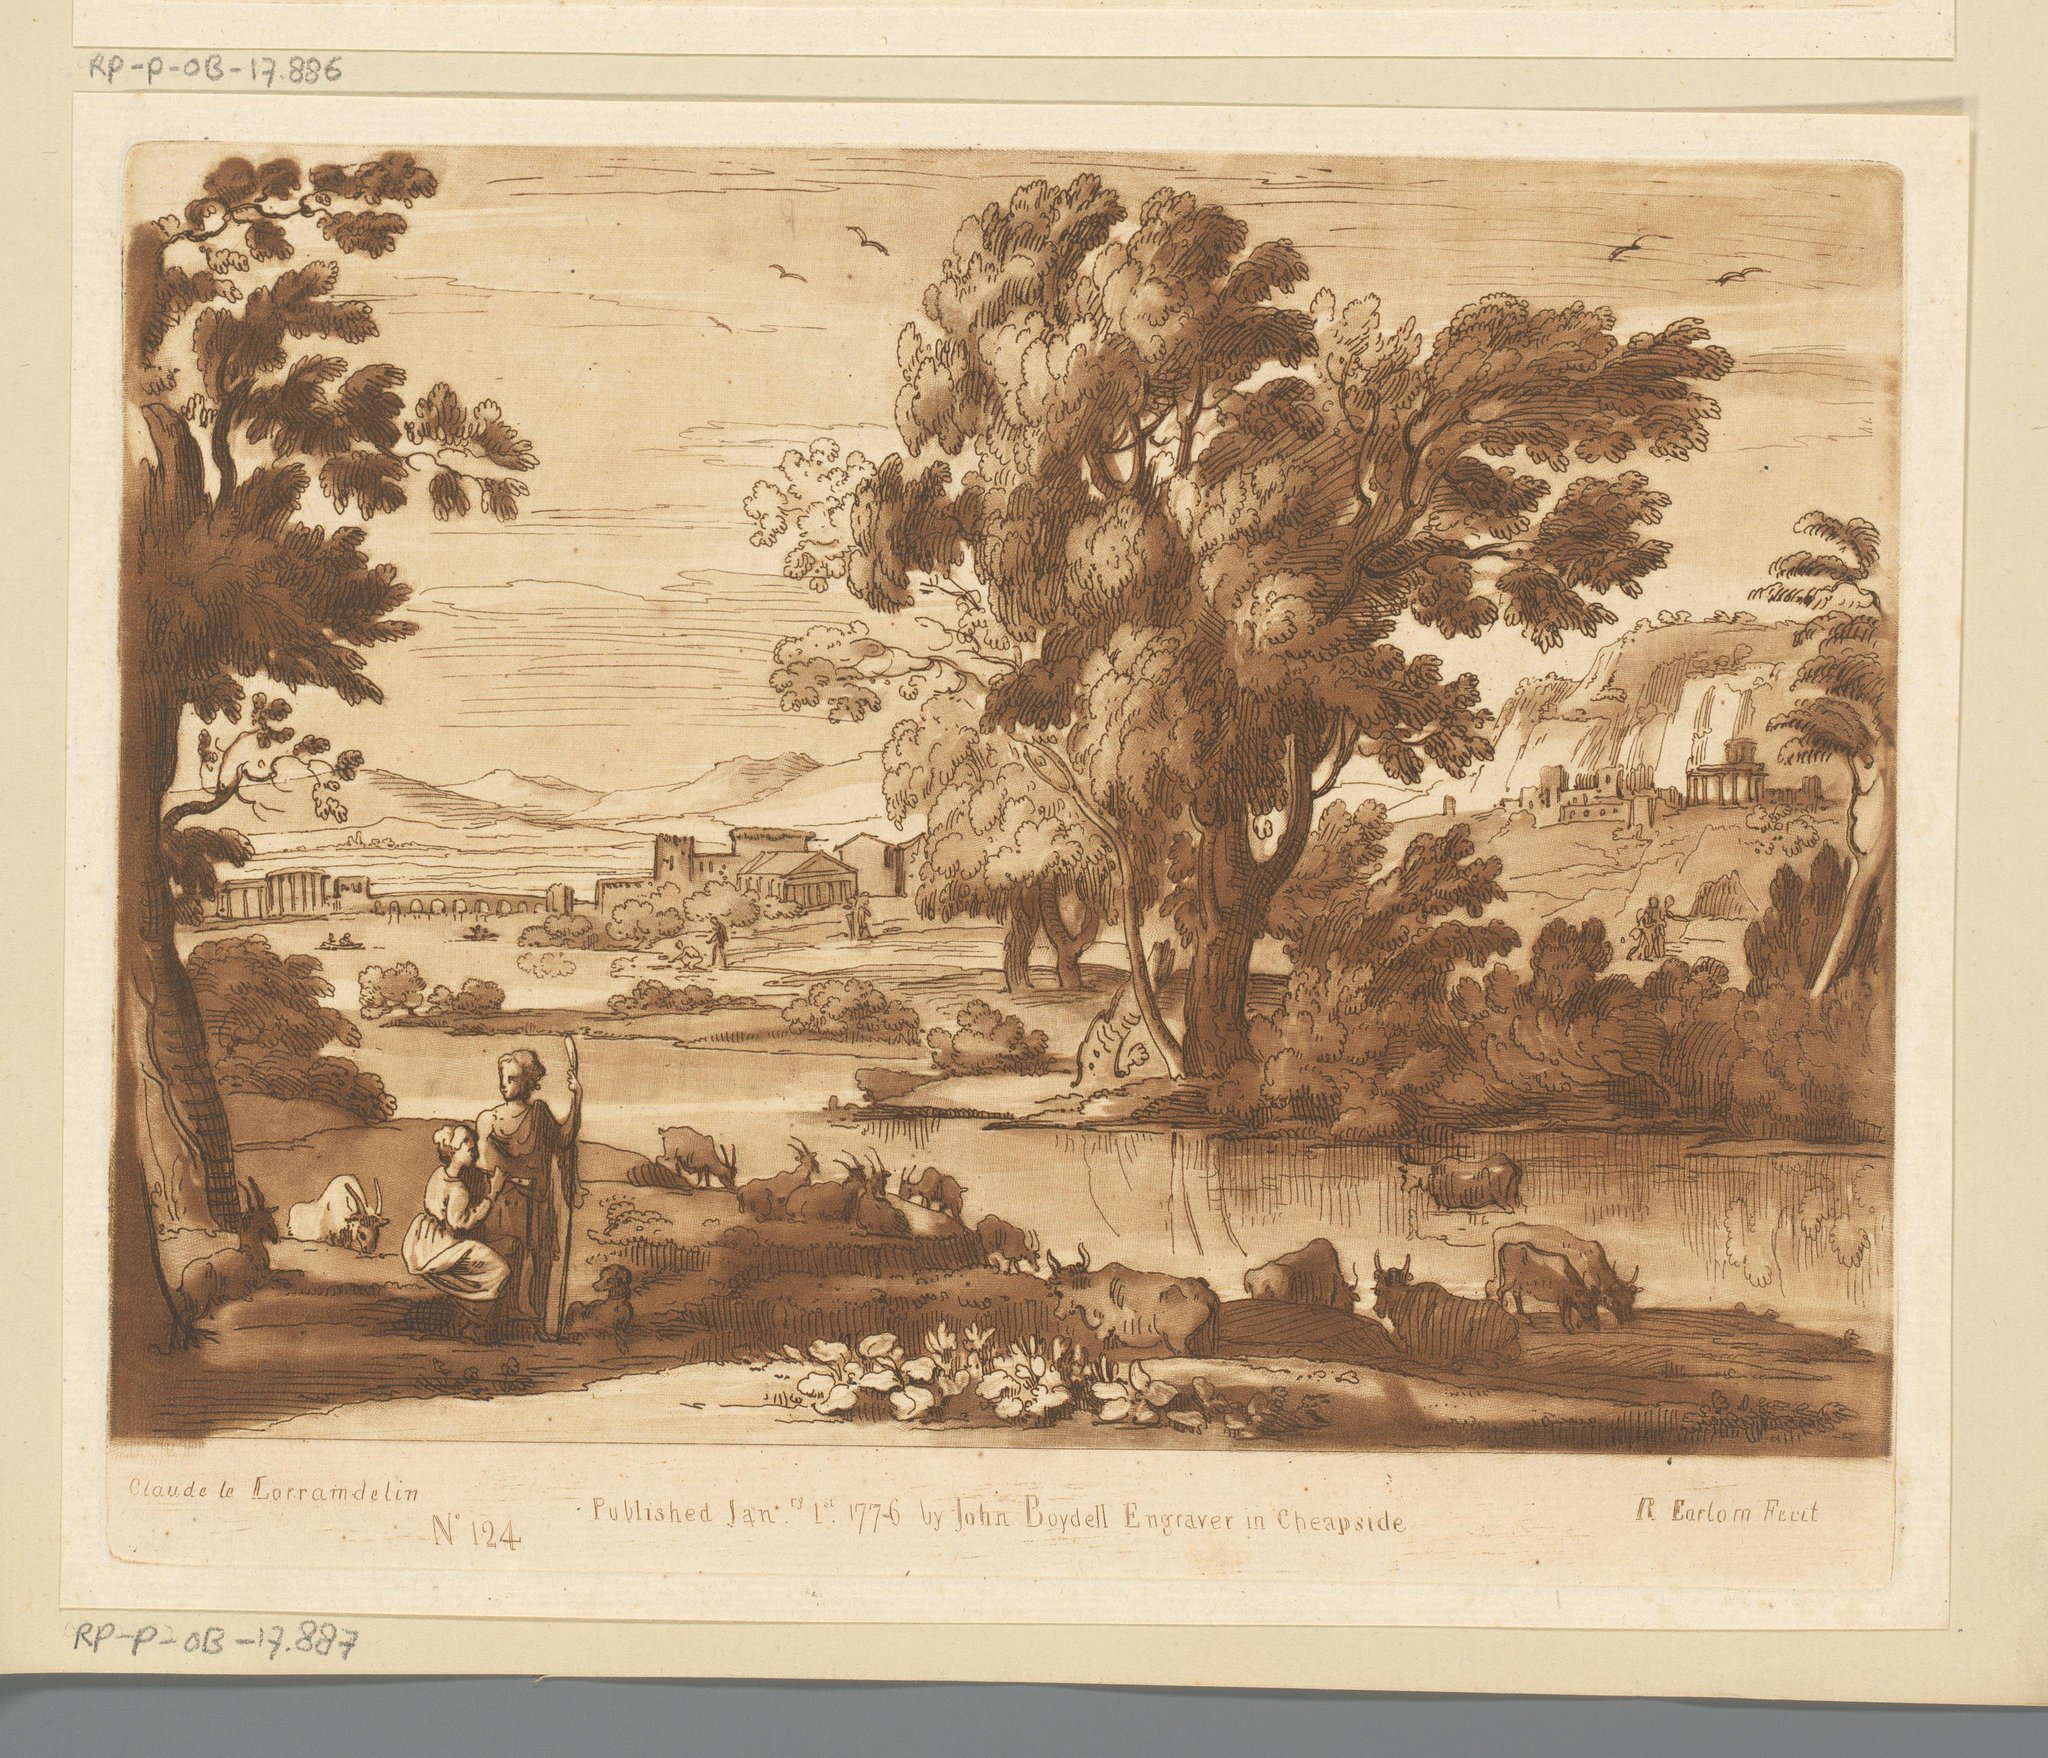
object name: print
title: Landschap met herderspaar en vee aan rivieroever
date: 1776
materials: paper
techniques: etching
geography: london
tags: river - hh - ideal landscapes, herding, herdsman, herdswoman, shepherd, shepherdess, cowherd, etc., cattle, village - ii - ideal landscapes, pastorals, arcadian scenes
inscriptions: date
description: Vanaf 1774 publiceerde John Boydell tweehonderd prenten naar het tekeningenboek Liber Veritatis van Claude Lorrain, in het bezit van de hertogen van Cavendish. Deze prenten werden vanaf 1777 in twee volumes gebundeld uitgegeven.